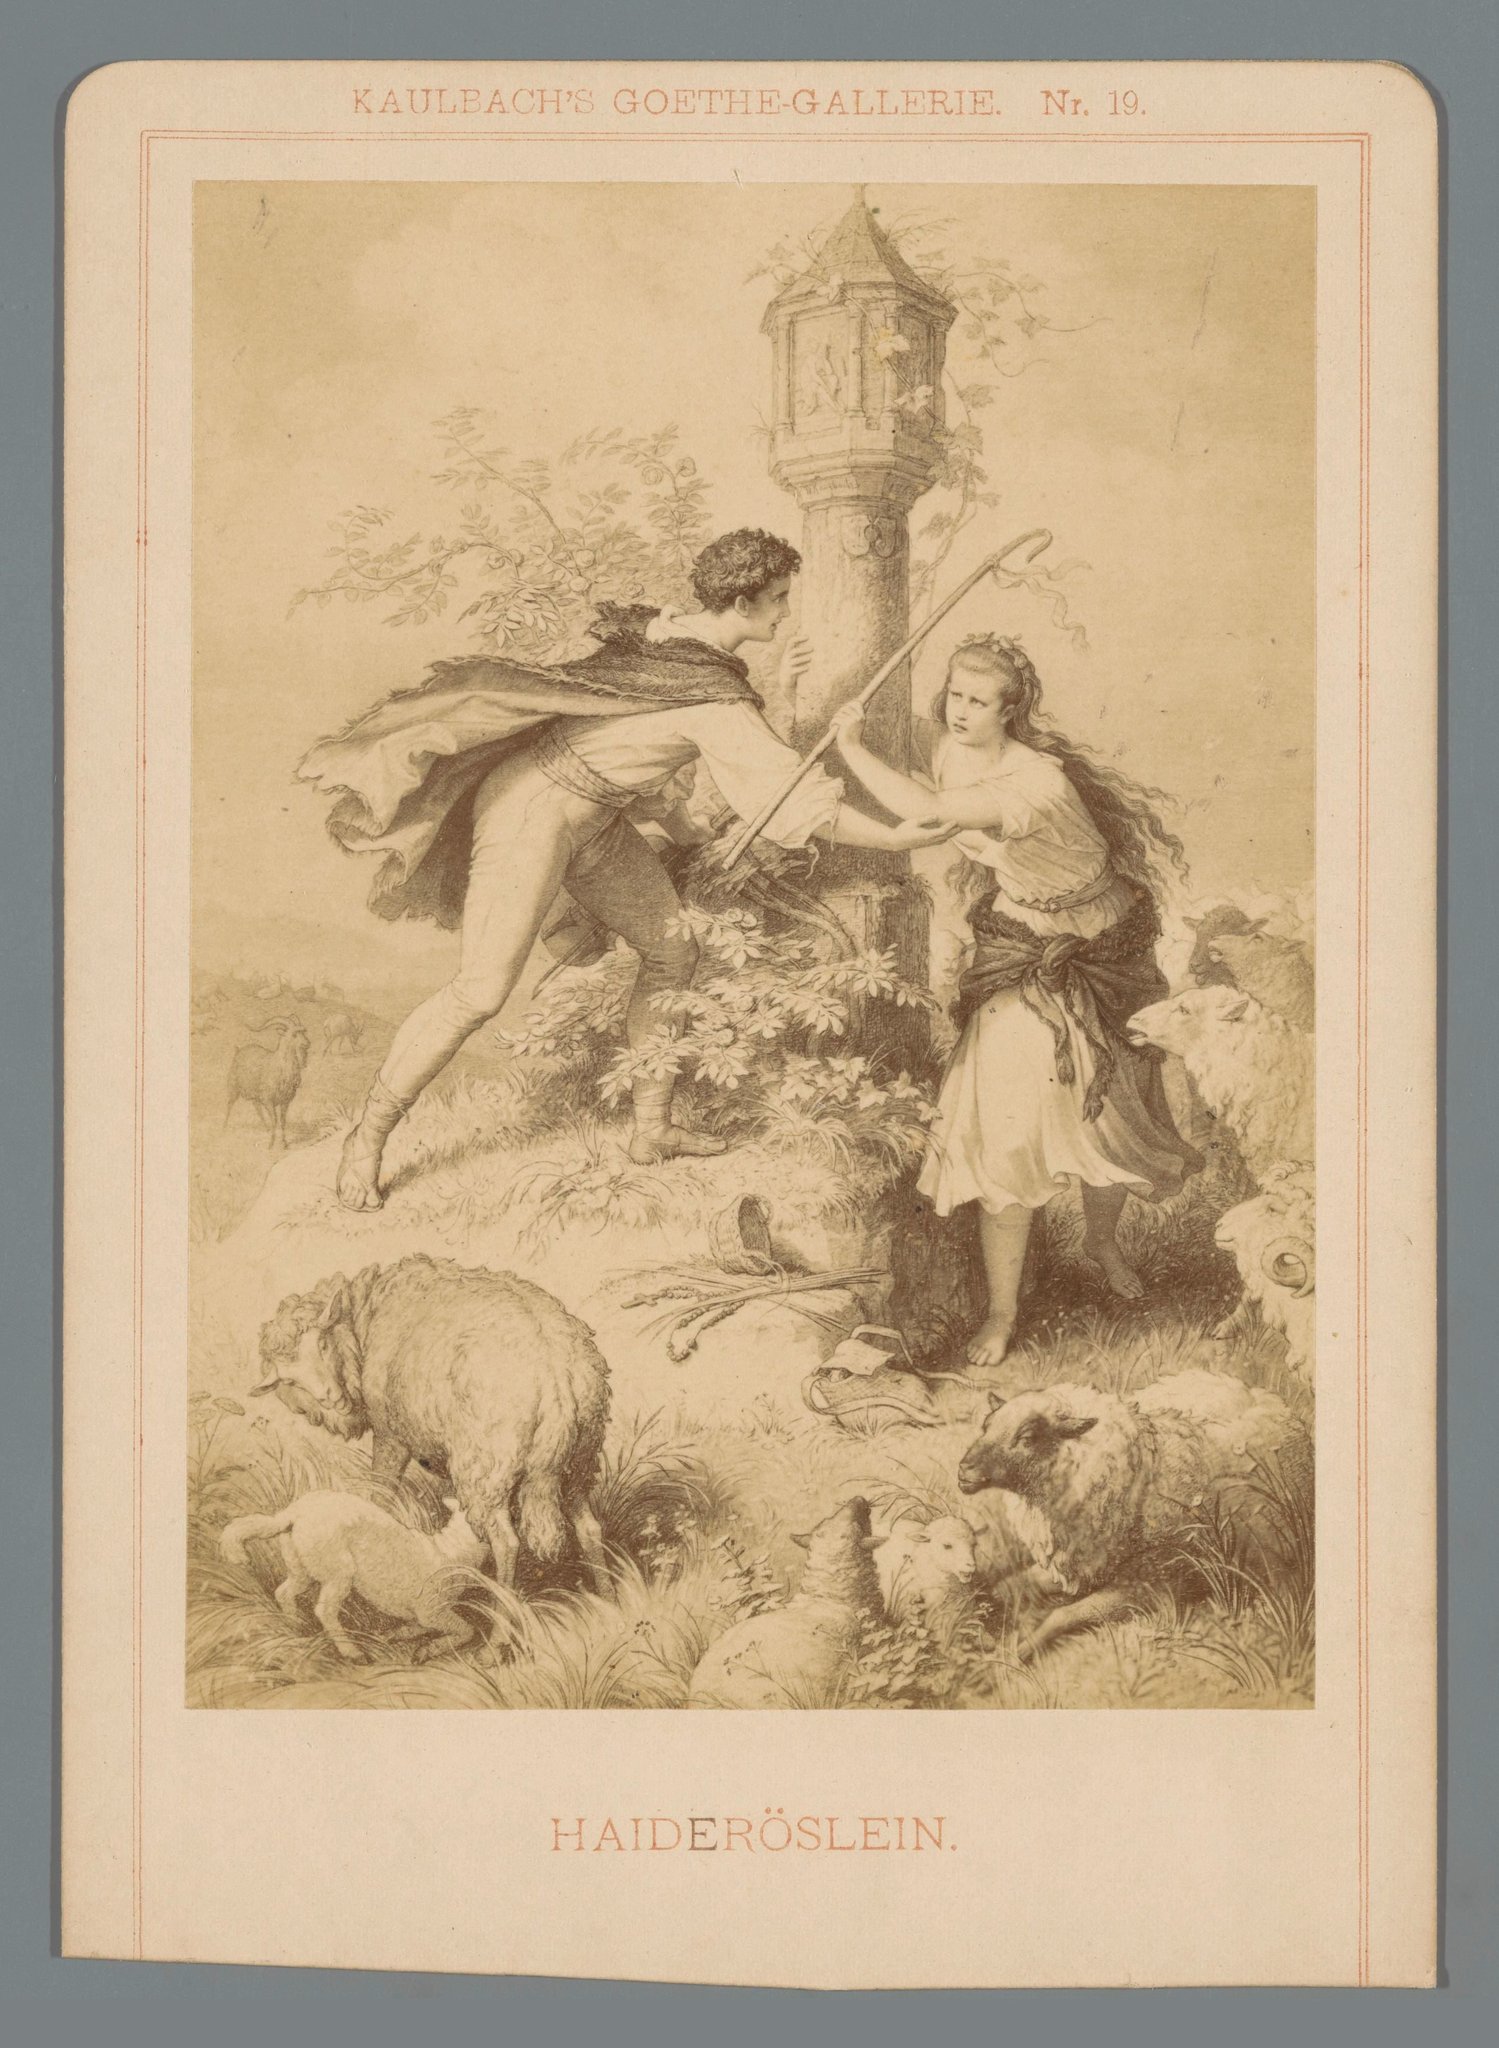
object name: cabinet photograph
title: Kaulbach's Goethe-Gallerie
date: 1875-1910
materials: cardboard, photographic support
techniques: albumen print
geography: rotterdam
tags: herding, herdsman, herdswoman, shepherd, shepherdess, cowherd, etc.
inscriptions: name: ‘Adr. Koller Boekhandelaar Hoofdsteeg 19 Roterdam’, number: ‘Nr. 19.’